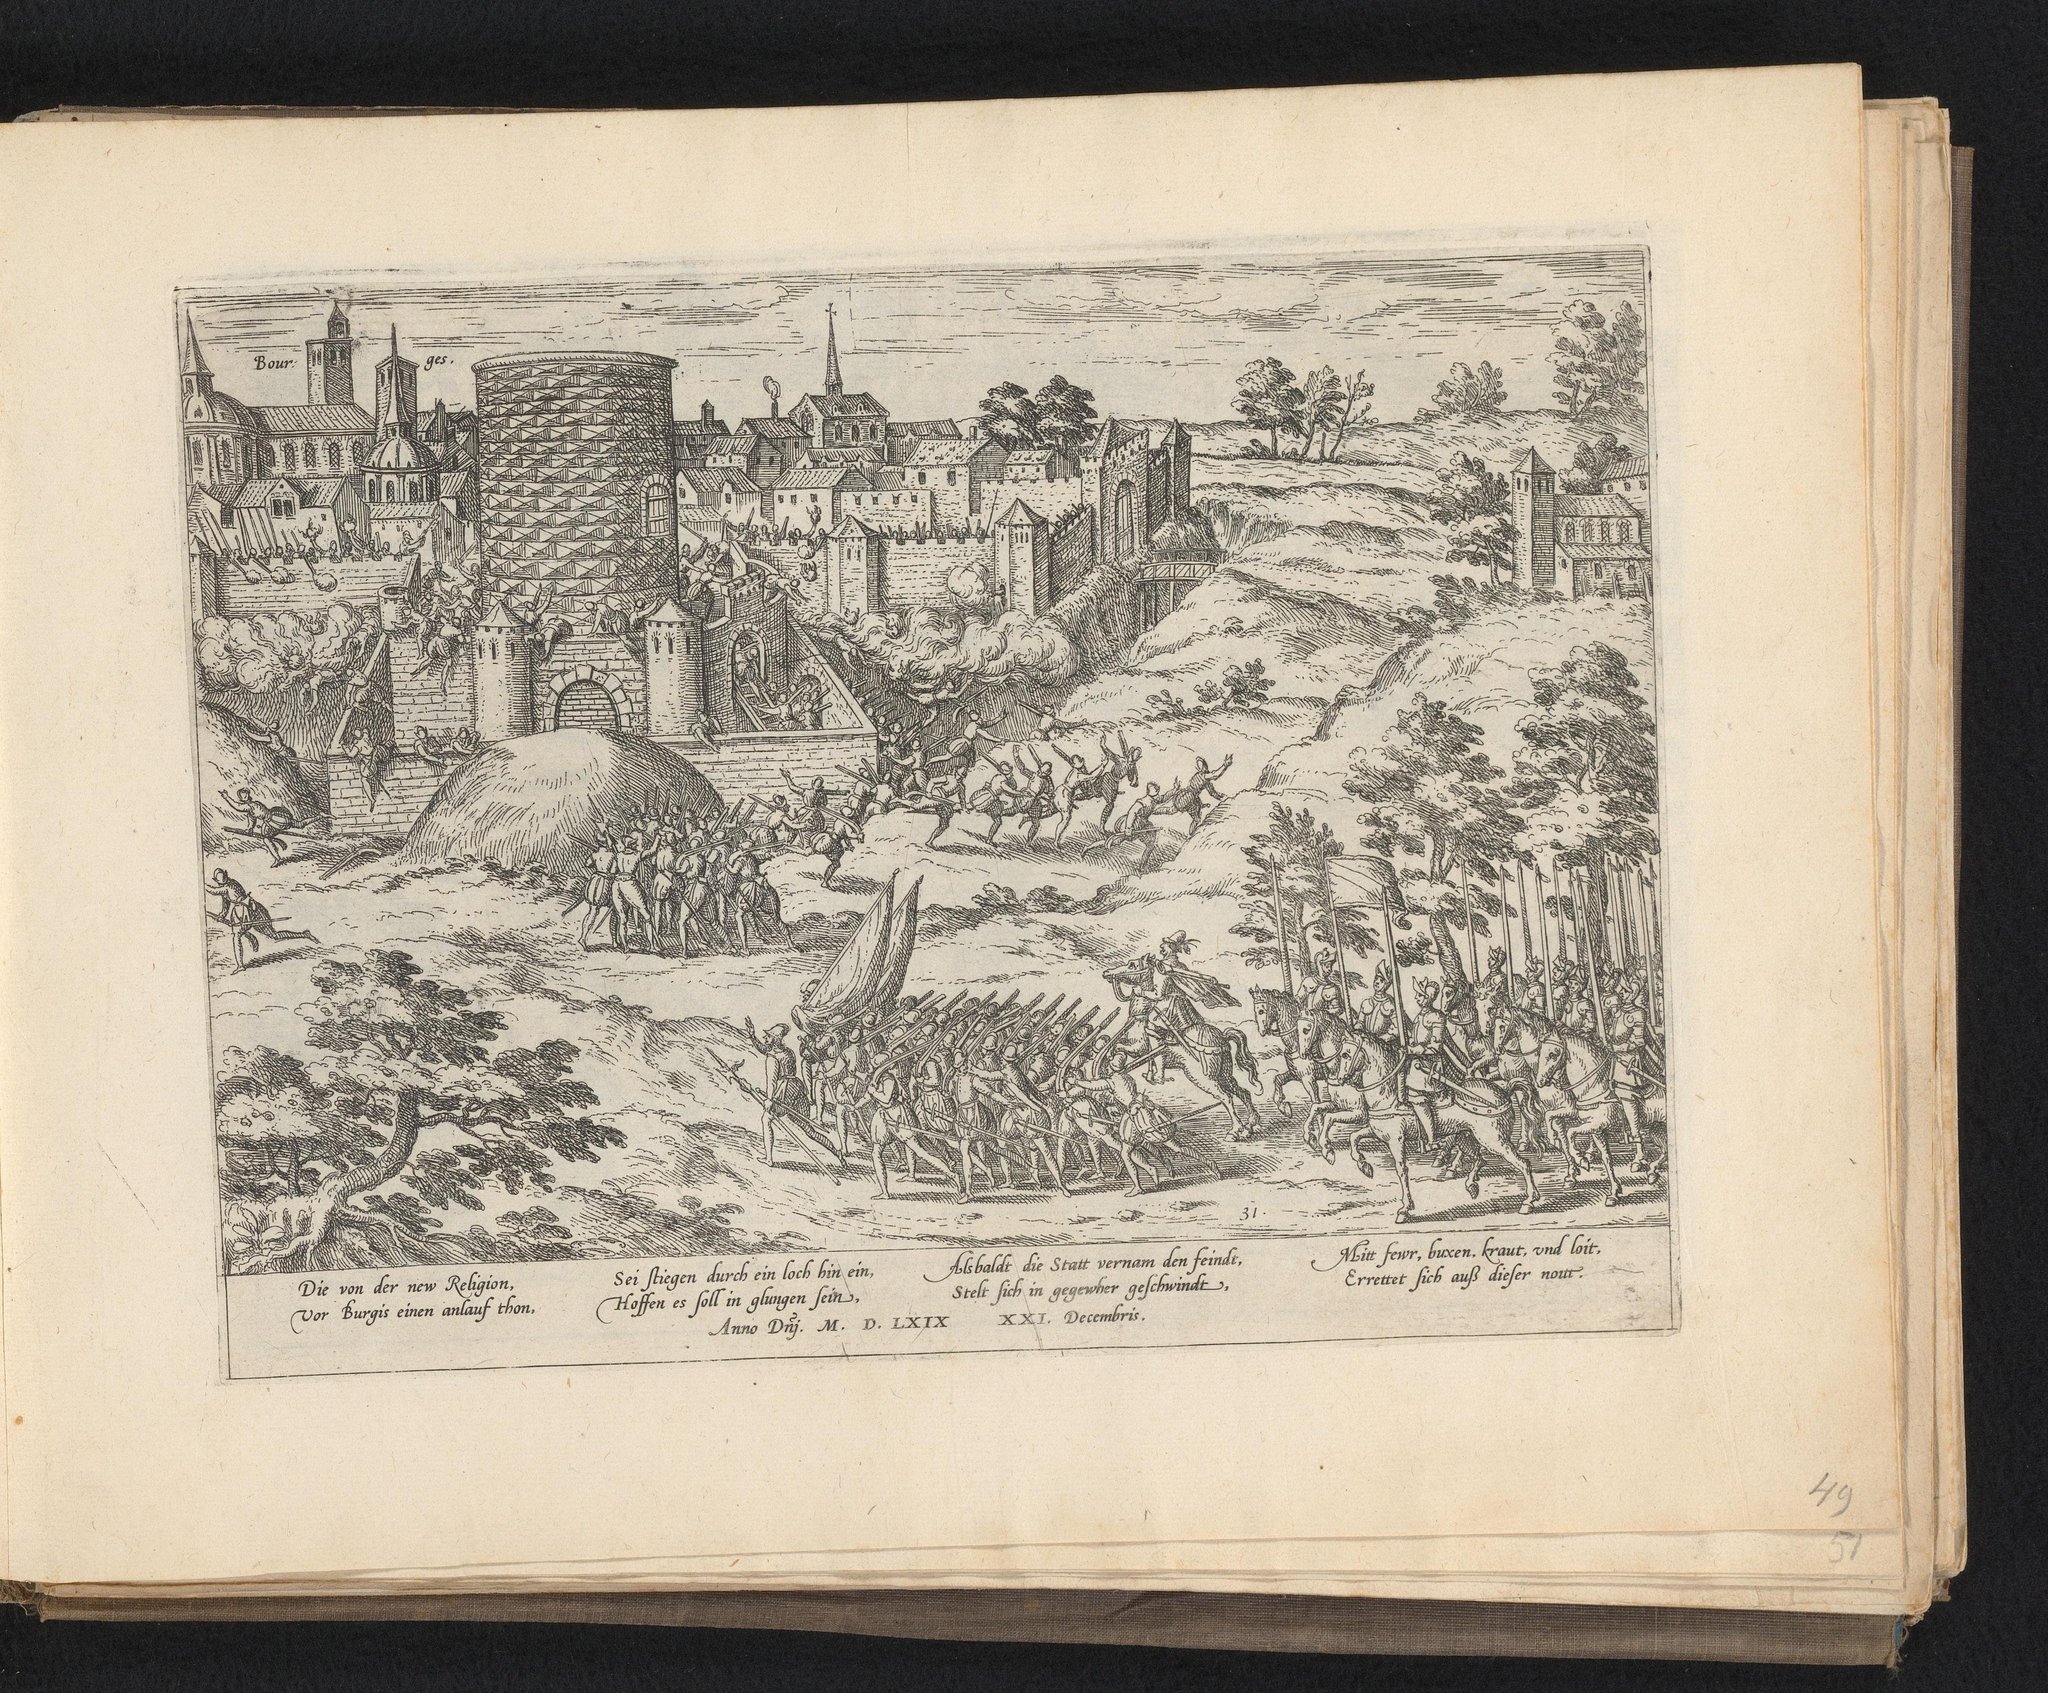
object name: print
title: Folge 3: Der Französische Religionskrieg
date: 1569-1573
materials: paper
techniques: etching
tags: siege, position war, militant proselytizing: religious war, crusade, etc., the roman catholic church vs. protestantism; (reformation and counter reformation)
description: Prent gebruikt in: Aitsinger, Michael. De Leone Belgico (...). Keulen: s.n., 1588.